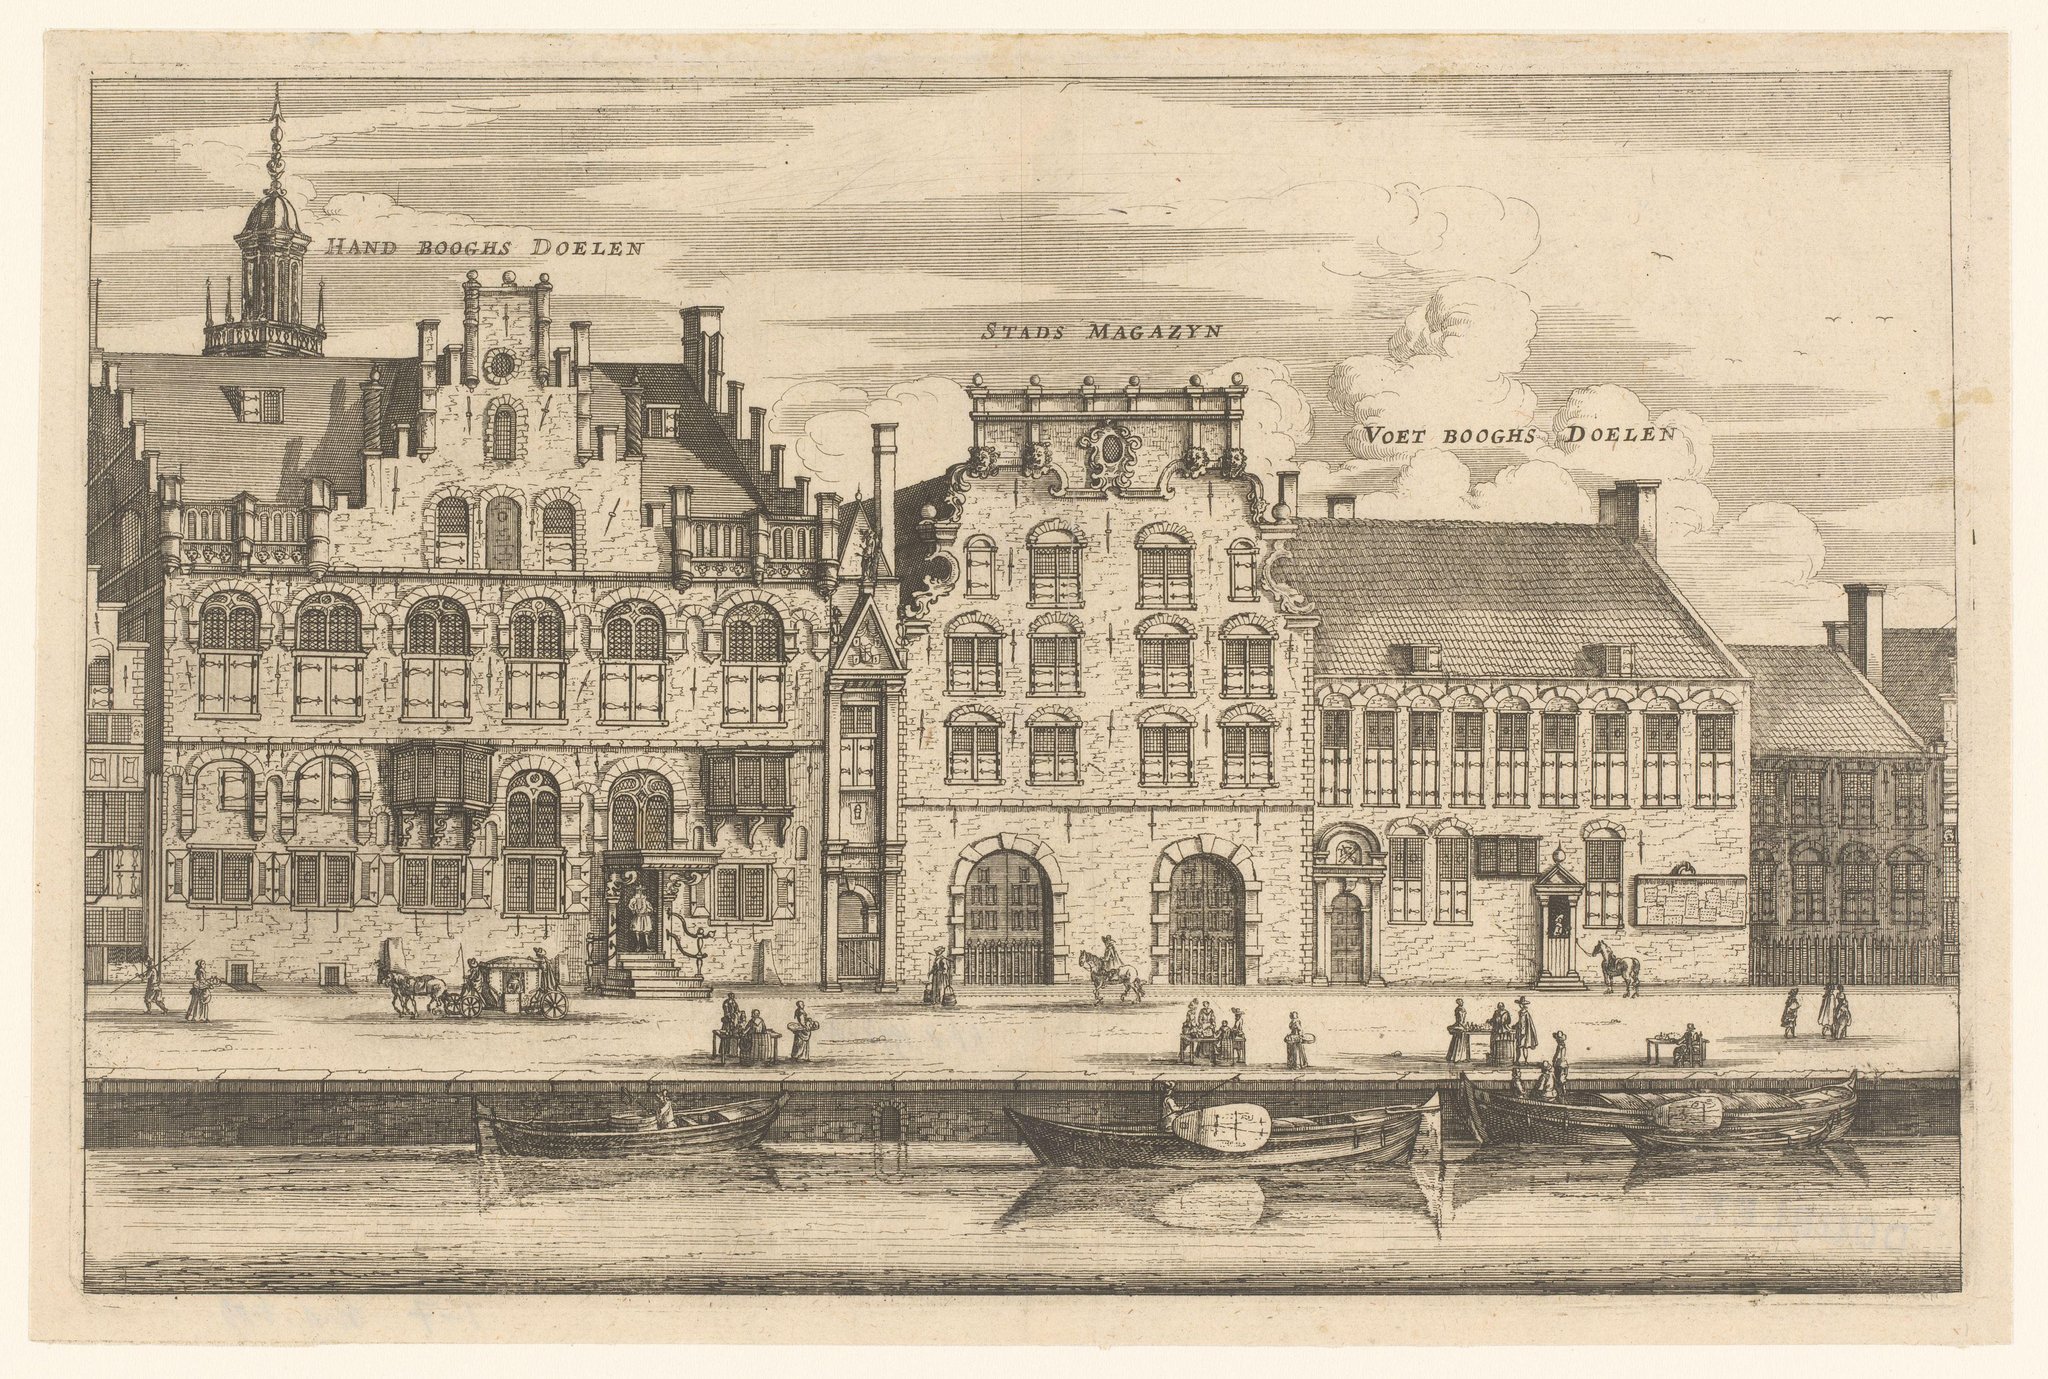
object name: book illustration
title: Gezicht op de Handboogdoelen, het Stadsmagazijn (Bushuis) en de Voetboogdoelen te Amsterdam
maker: jacob van meurs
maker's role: draughtsman, print maker, publisher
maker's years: 1619-1680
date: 1663-1664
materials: paper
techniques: engraving, etching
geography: amsterdam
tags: land forces (+ citizen soldiery, civil guard, citizen militia), ammunition store, arsenal, street (+ city(-scape) with figures, staffage)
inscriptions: stamp: ‘doublet.’, collector's mark: Lugt 2228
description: Prent waarschijnlijk uit: Dapper, Olfert. Historische beschryving der stadt Amsterdam: waer in de voornaemste geschiedenissen (na een kort verhael van gansch Hollant en d'omleggende dorpen (…). Amsterdam: Jacob van Meurs, 1663. Of uit: Zesen, Philipp von. Beschreibung der Stadt Amsterdam: darinnen von derselben ersten Ursprunge bis auf gegenwärtigen Zustand (…). Amsterdam: Joachim Nosche, 1664. In sommige exemplaren van de uitgave van Van Meurs komt een tweede staat voor met Franse titel boven de Nederlandse.